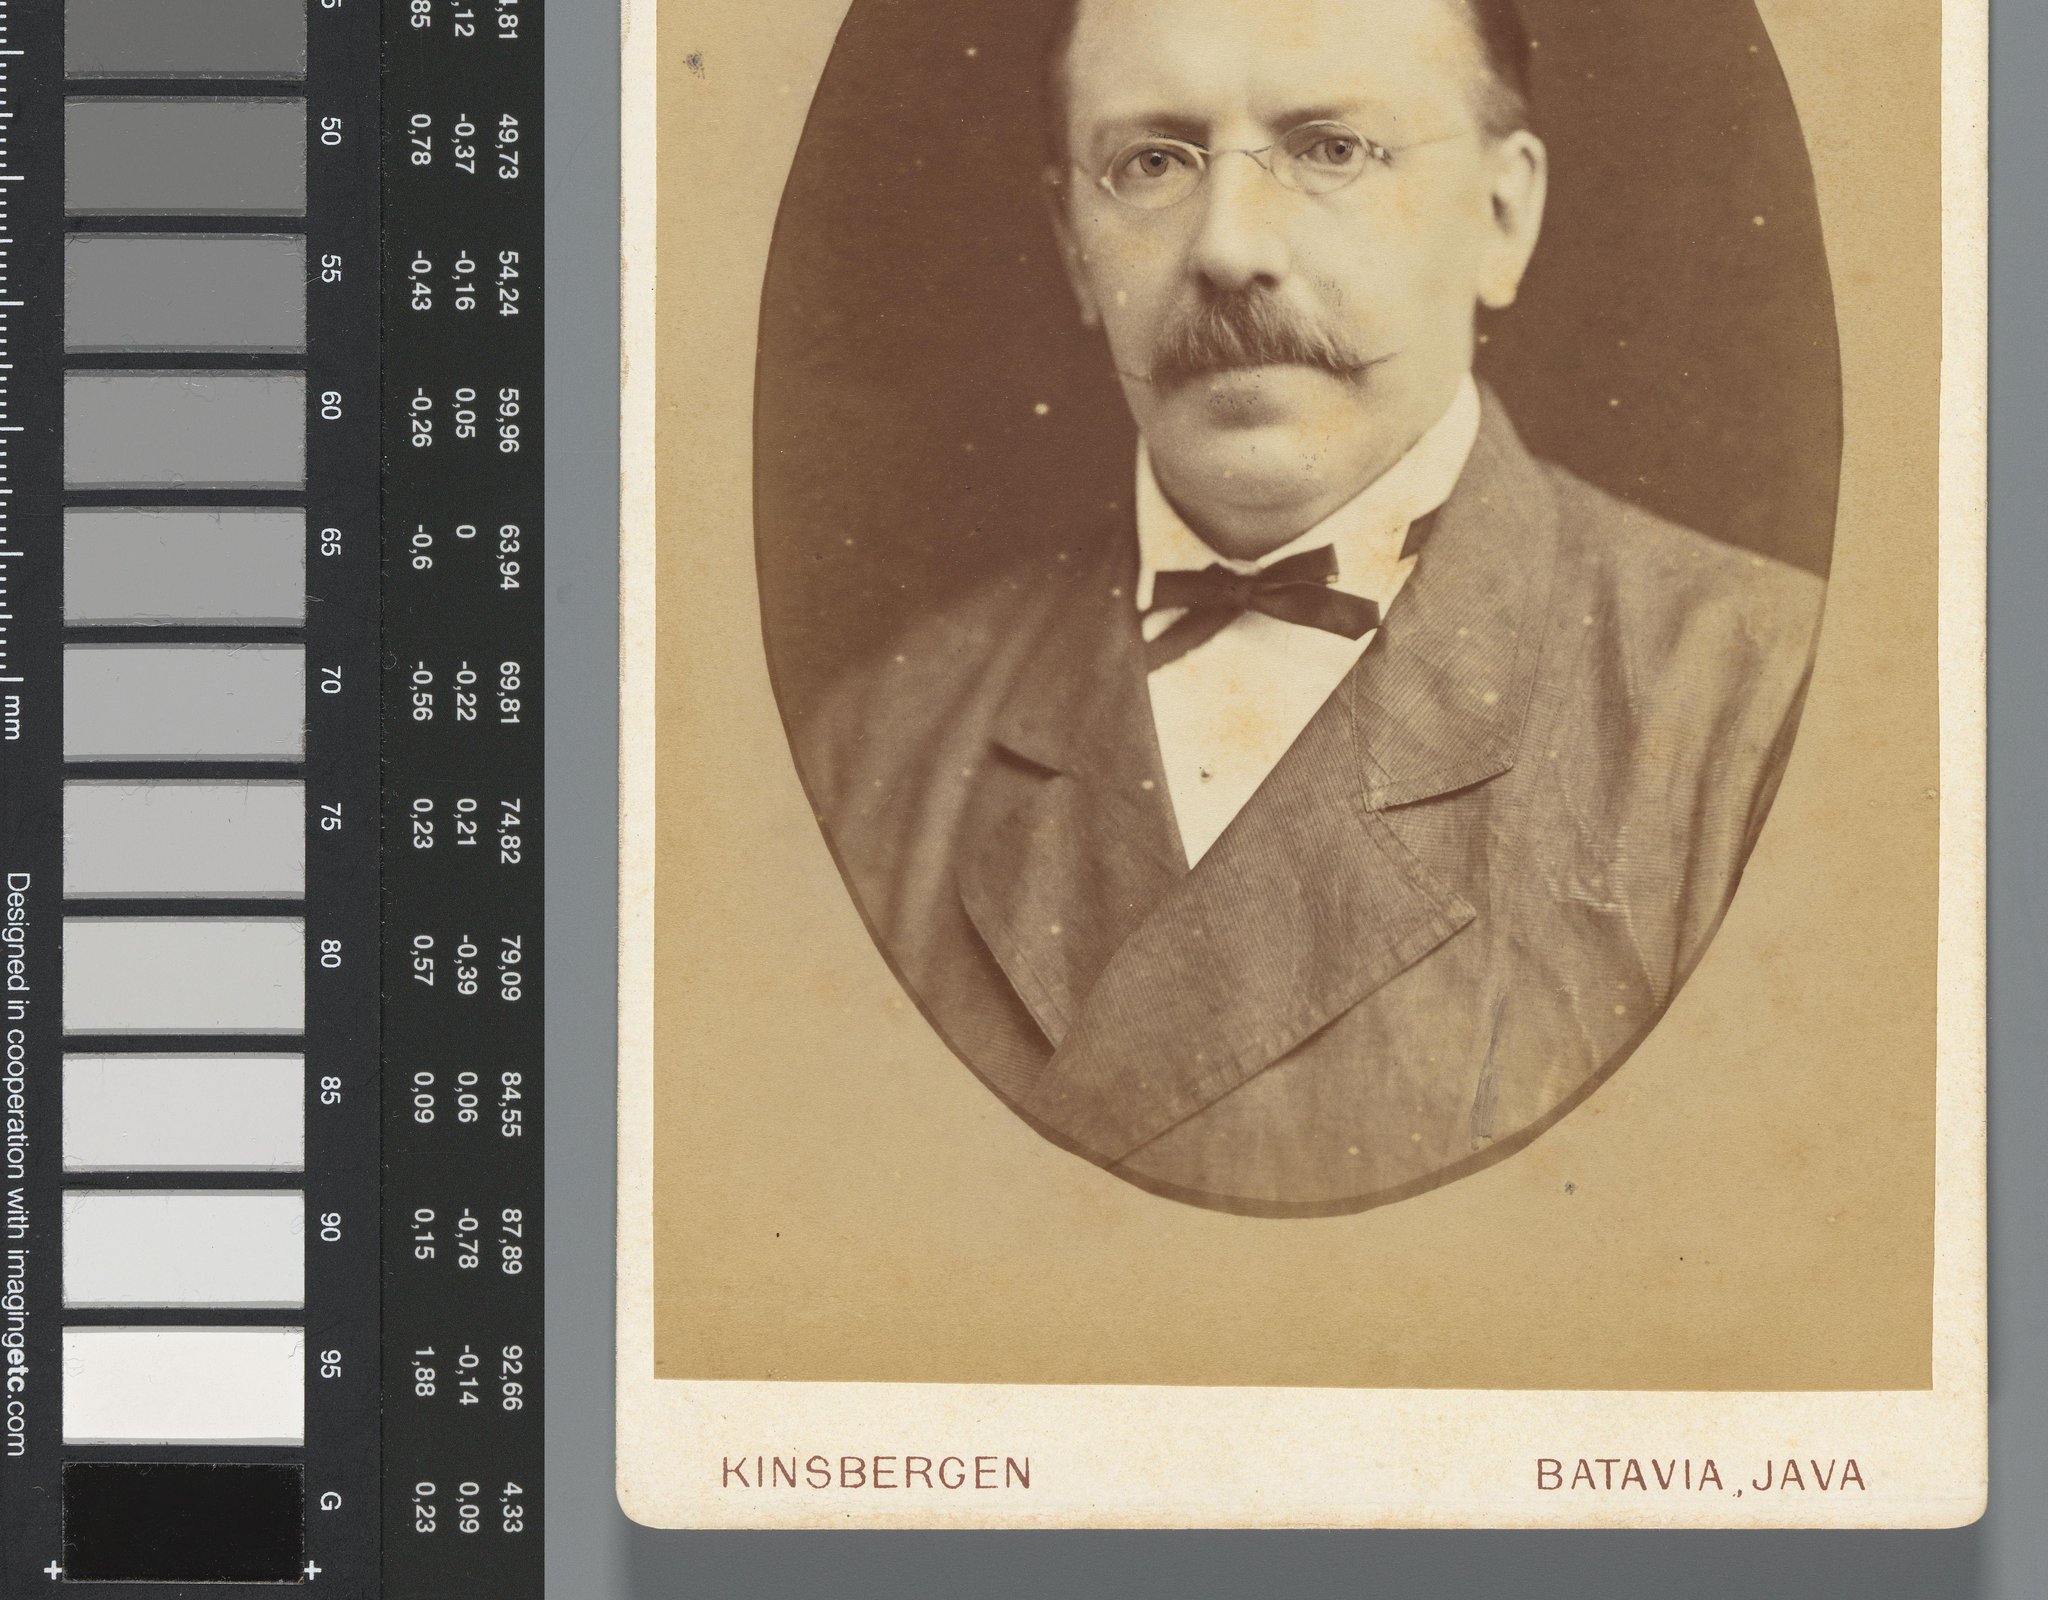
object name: photograph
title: Portret van Norbert van den Berg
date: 1855-1910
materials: cardboard, photographic support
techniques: albumen print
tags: rotterdam, amsterdam, norbertus petrus van den berg (1831-1917)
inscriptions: name: ‘KINSBERGEN BATAVIA, JAVA’, inscription: ‘Norbertus Petrus van den Berg / geb. R'dam 5/11 1831 / overl. A'dam 8/1 1917 / 86 jaar oud geworden / man van / Carolina Fredrika Holle / geb. Koblenz 4/7 1840 / overl. Amsterdam 28/7 1909’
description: Portret van Norbert van den Berg in ovaal.